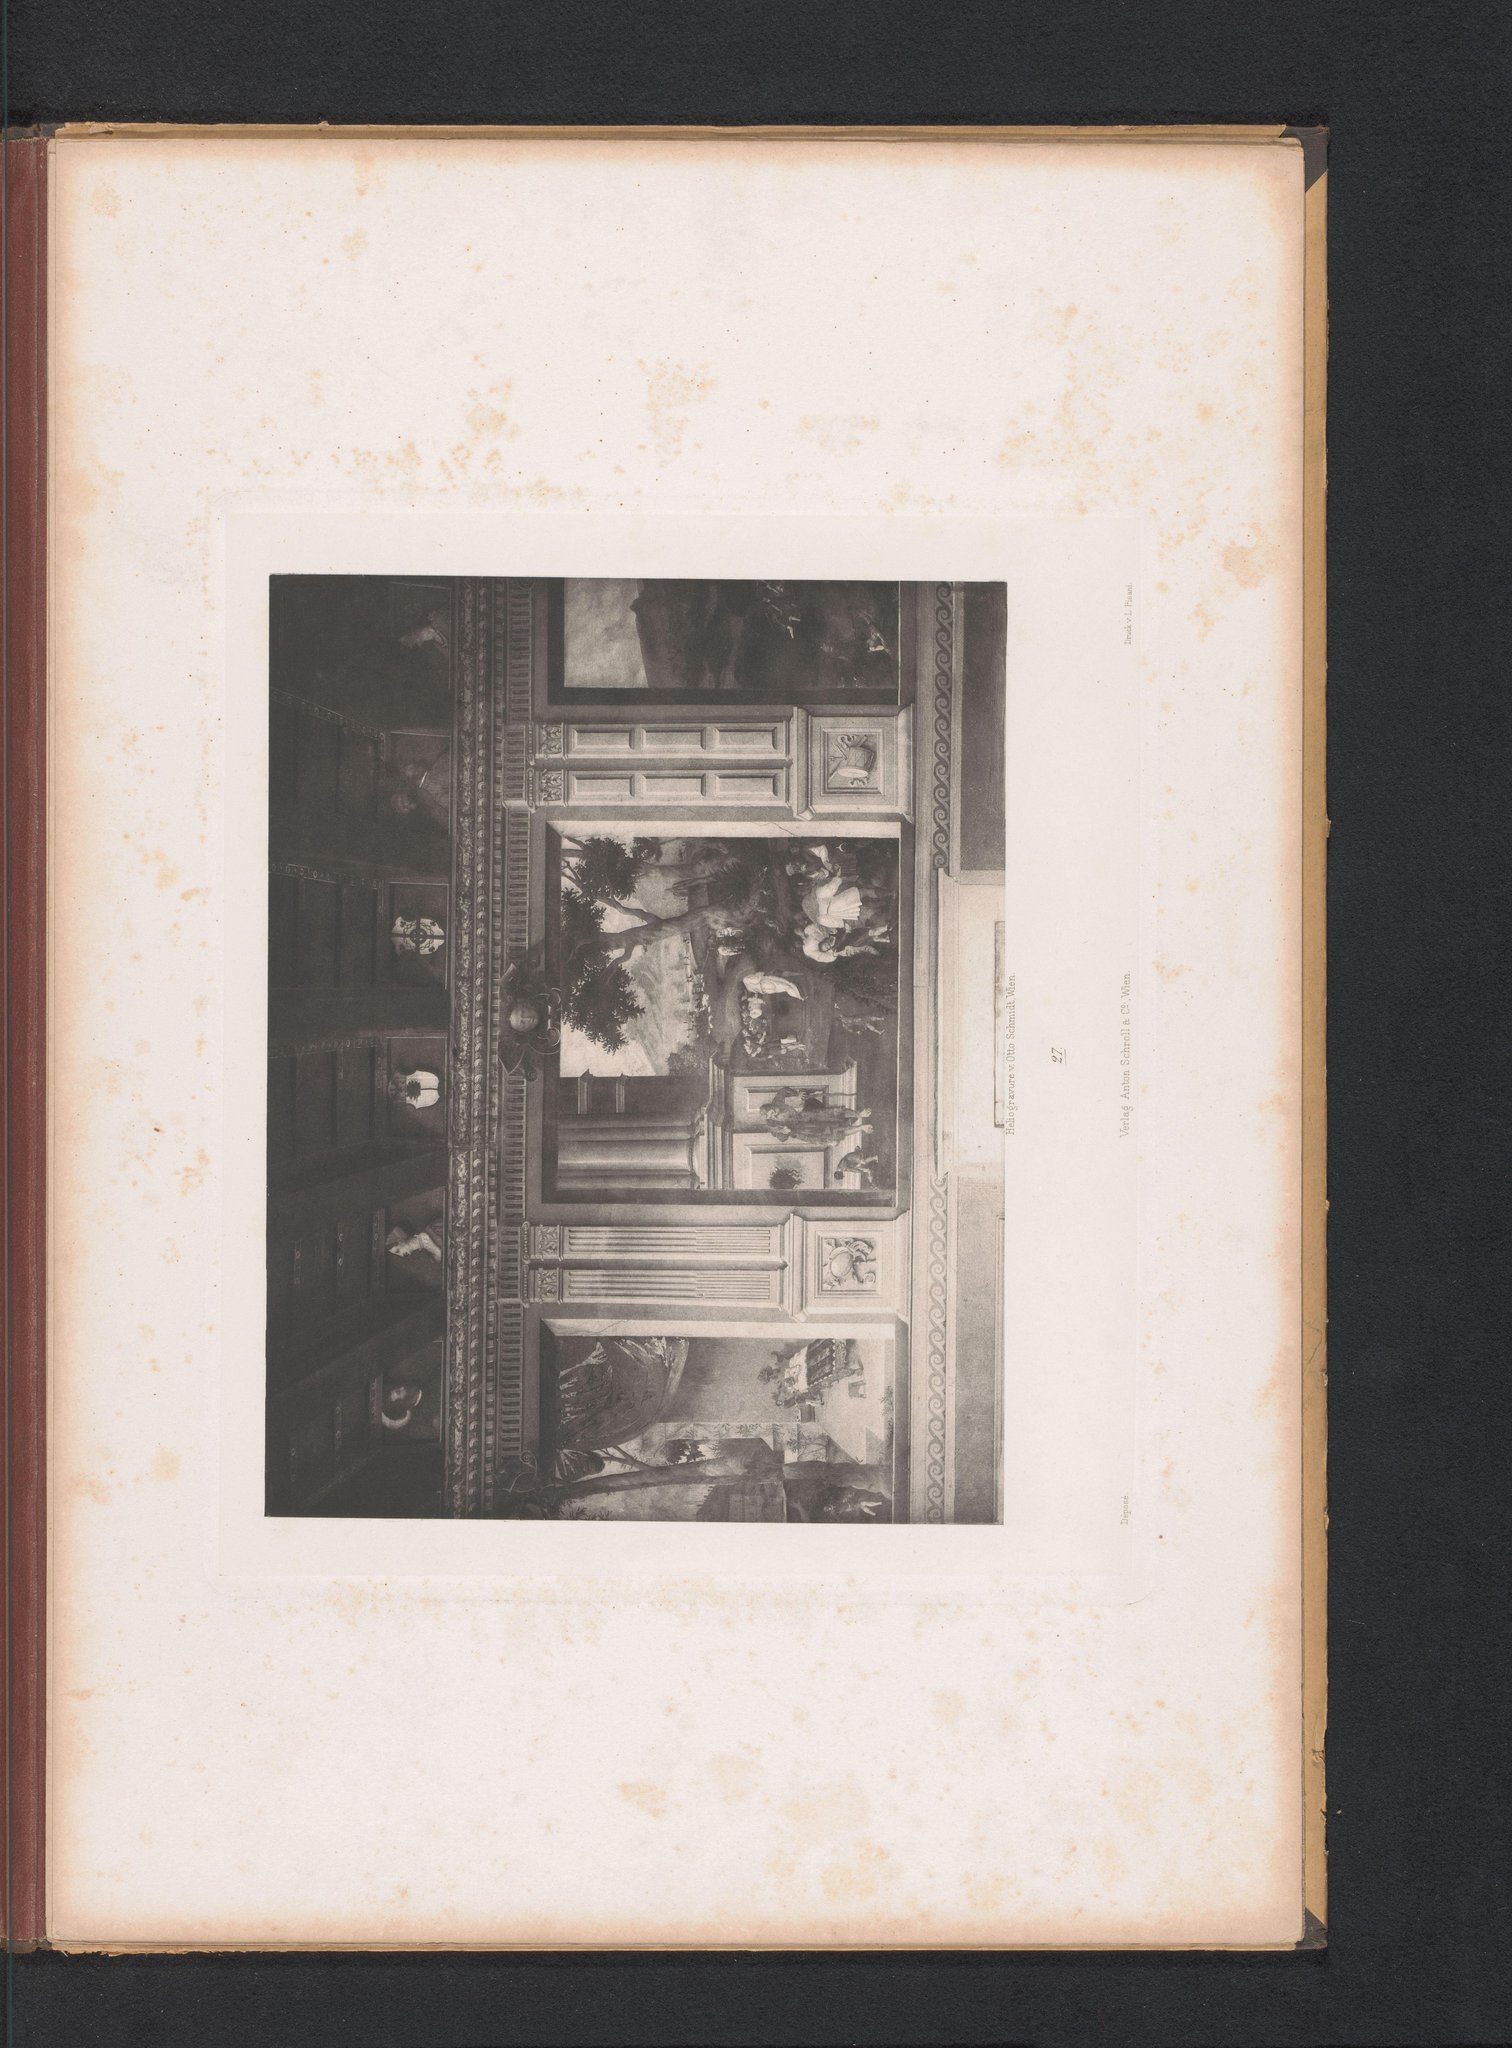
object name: photomechanical print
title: Wandschilderingen in Villa Margon in Trento, Italië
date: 1888-1893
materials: paper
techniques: photoaquatint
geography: vienna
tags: villa, picture, painting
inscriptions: inscription: ‘Déposé.’, number: ‘27.’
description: Deze prent maakt deel uit van een omslag met twintig prenten, twee tekstbladen en een titelpagina.